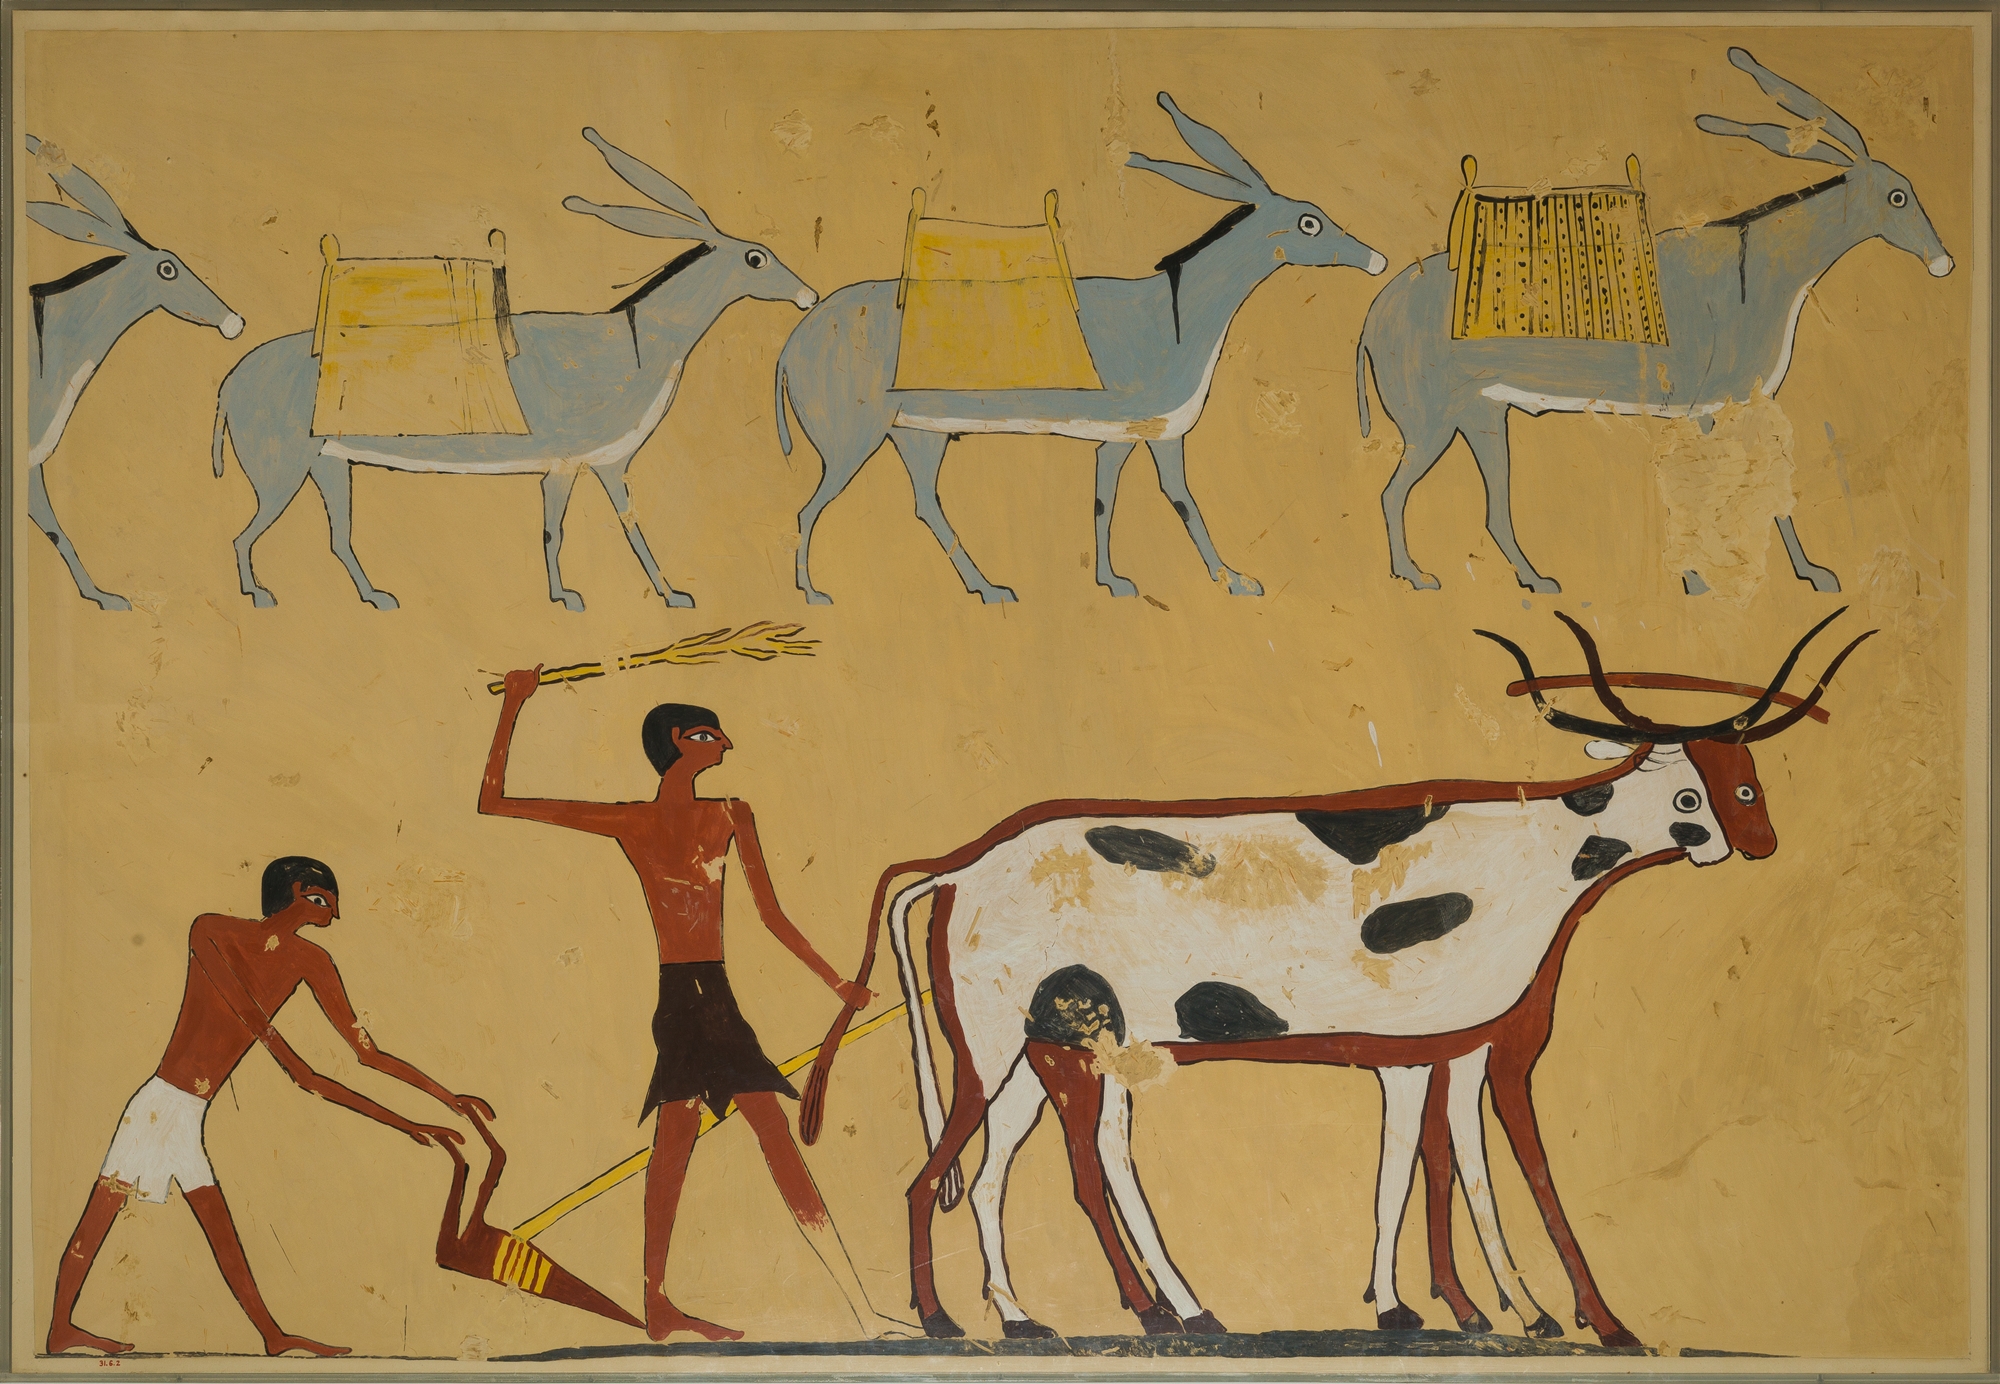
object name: facsimile, djari tt 366, mma 820, plowing, donkey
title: Laden Donkeys and Ploughing, Tomb of Djar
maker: nina de garis davies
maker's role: artist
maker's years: 1881-1965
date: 2060-2010 BCE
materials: ink, paint, paper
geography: egypt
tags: men,donkeys,working,ox